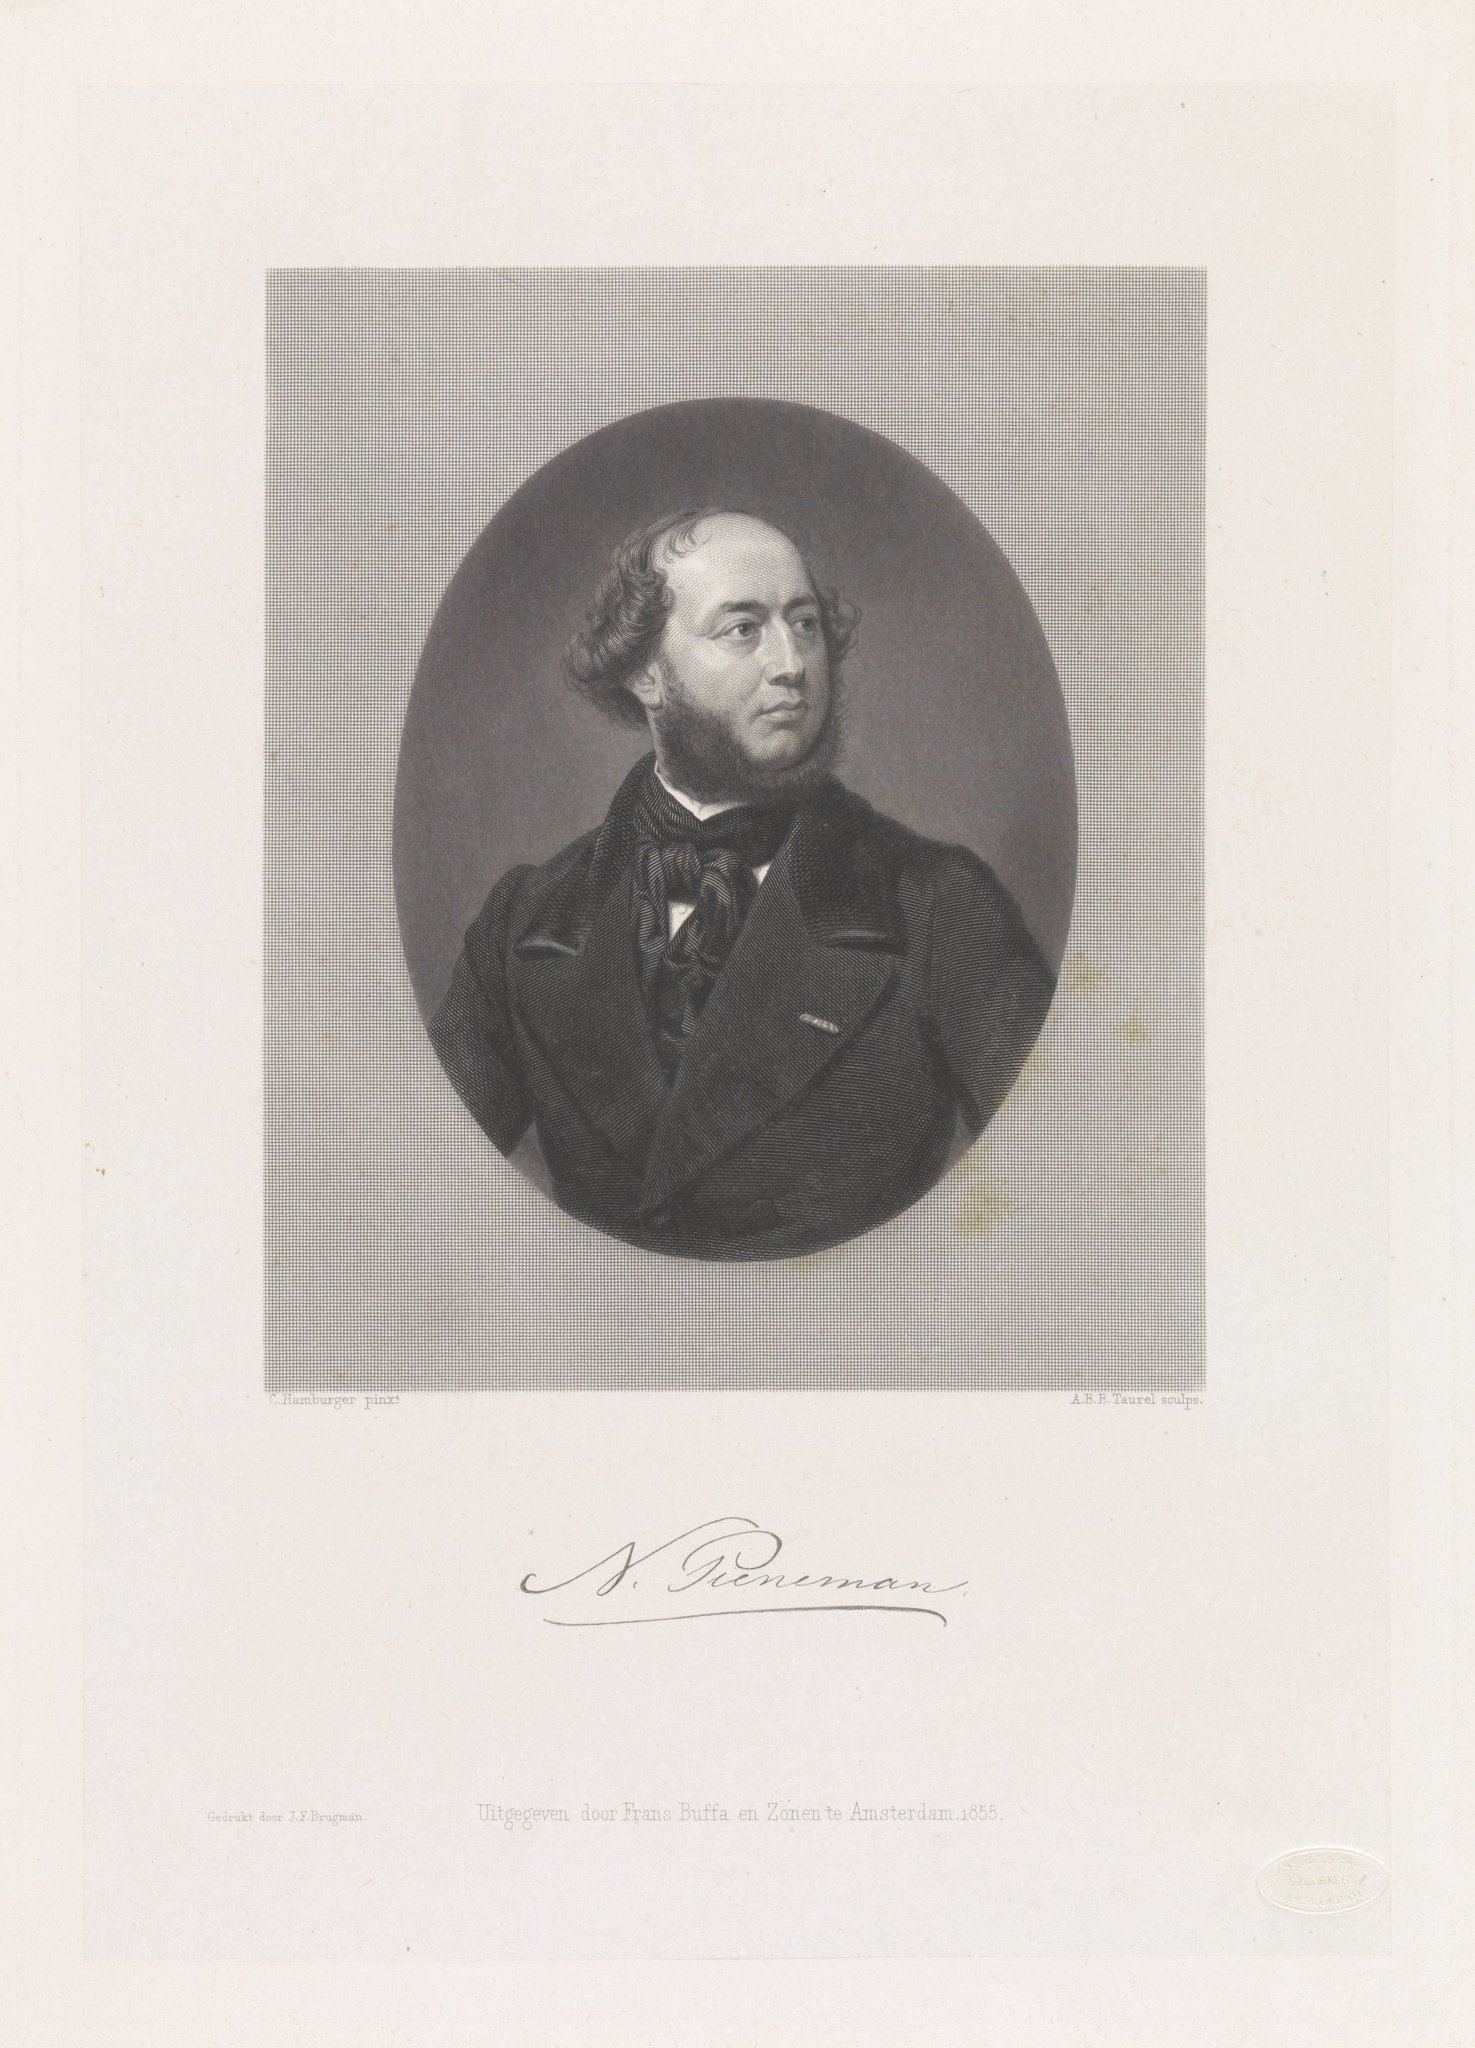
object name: print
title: Portret van Nicolaas Pieneman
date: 1855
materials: paper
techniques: engraving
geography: amsterdam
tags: amsterdam, painter, print maker, draughtsman, nicolaas pieneman, historical persons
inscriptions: check stamp: ‘Frans Buffa en Zonen uitgevers Amsterdam’, collector's mark: Lugt 2166, collector's mark: Lugt 2760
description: Behoort tot de Verzameling Gerritsen, kunstenaarsportretten.